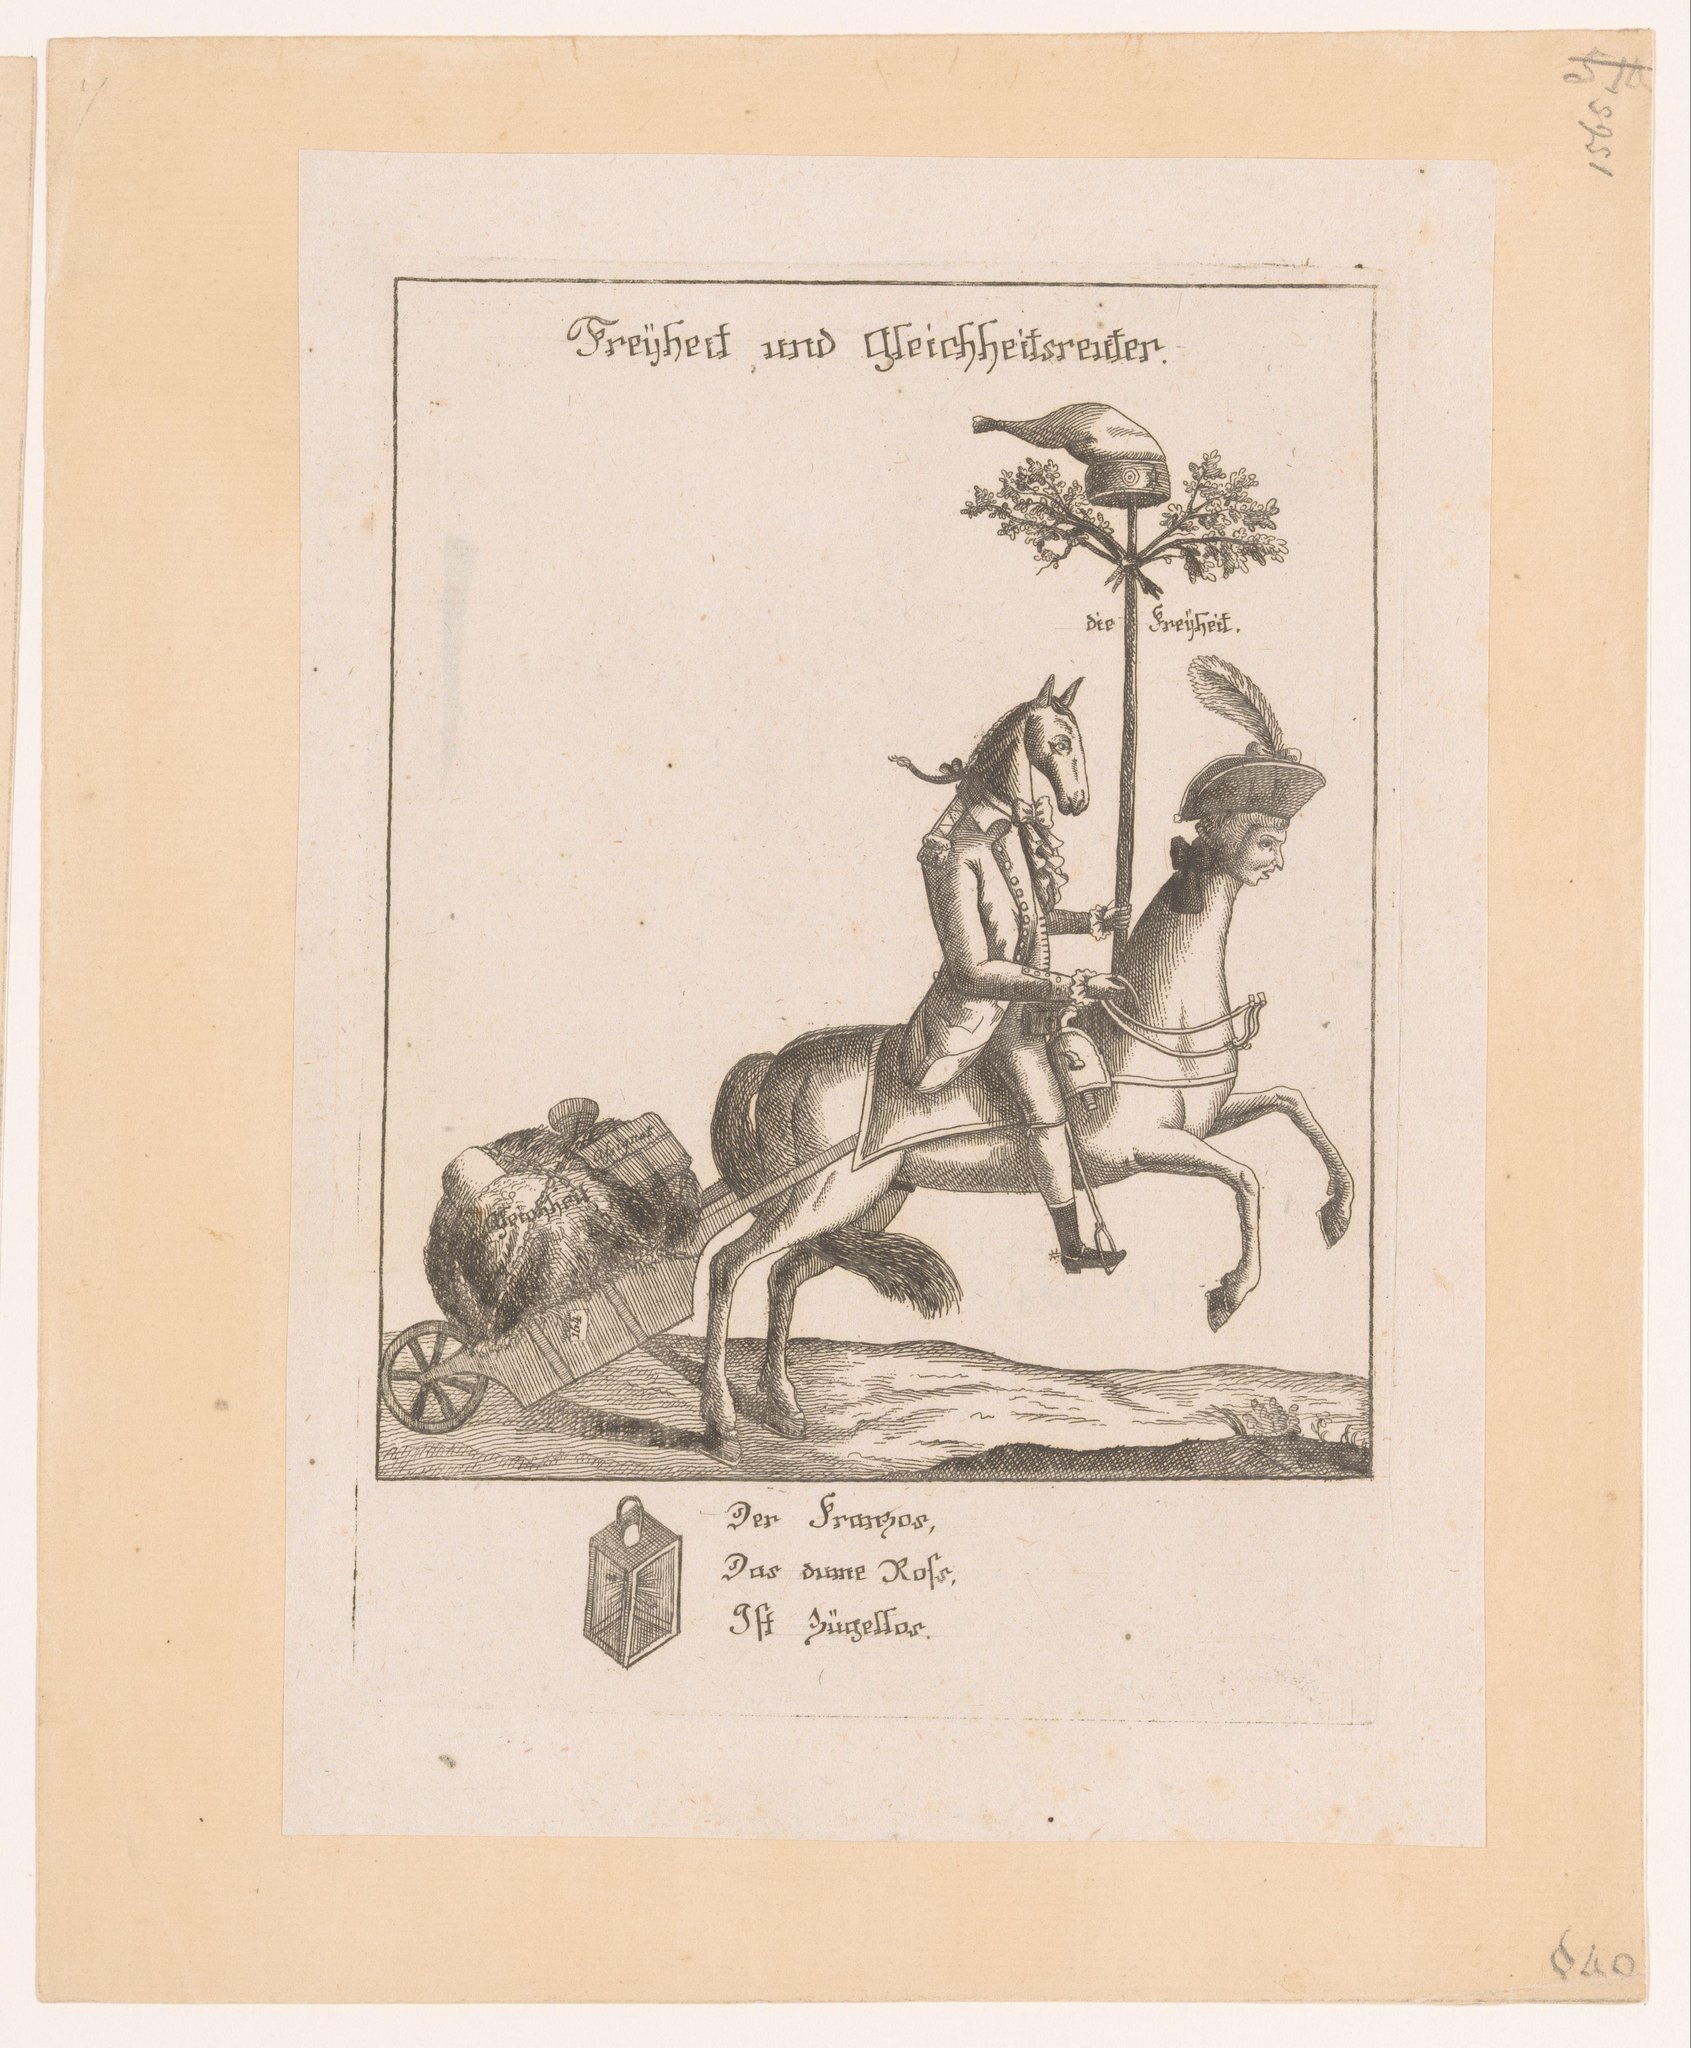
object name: cartoon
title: Spotprent op de Franse Revolutie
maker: Anonymous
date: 1793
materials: paper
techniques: etching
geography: germany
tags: political caricatures and satires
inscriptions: collector's mark: Lugt 2228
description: De spot wordt in deze prent gedreven met de revolutionaire orde in Frankrijk. De rollen van paard en ruiter zijn omgekeerd: een ruiter met een paardenhoofd berijdt een paard met het hoofd van een aristocraat. De teugels in de hand van de ruiter hangen los voor de nek van het dier. Vrijheid wordt dus gelijkgesteld met wetteloosheid. Het vrij rennen van het paard wordt echter belemmerd door een kar met rechters en geketende gelijkheid.